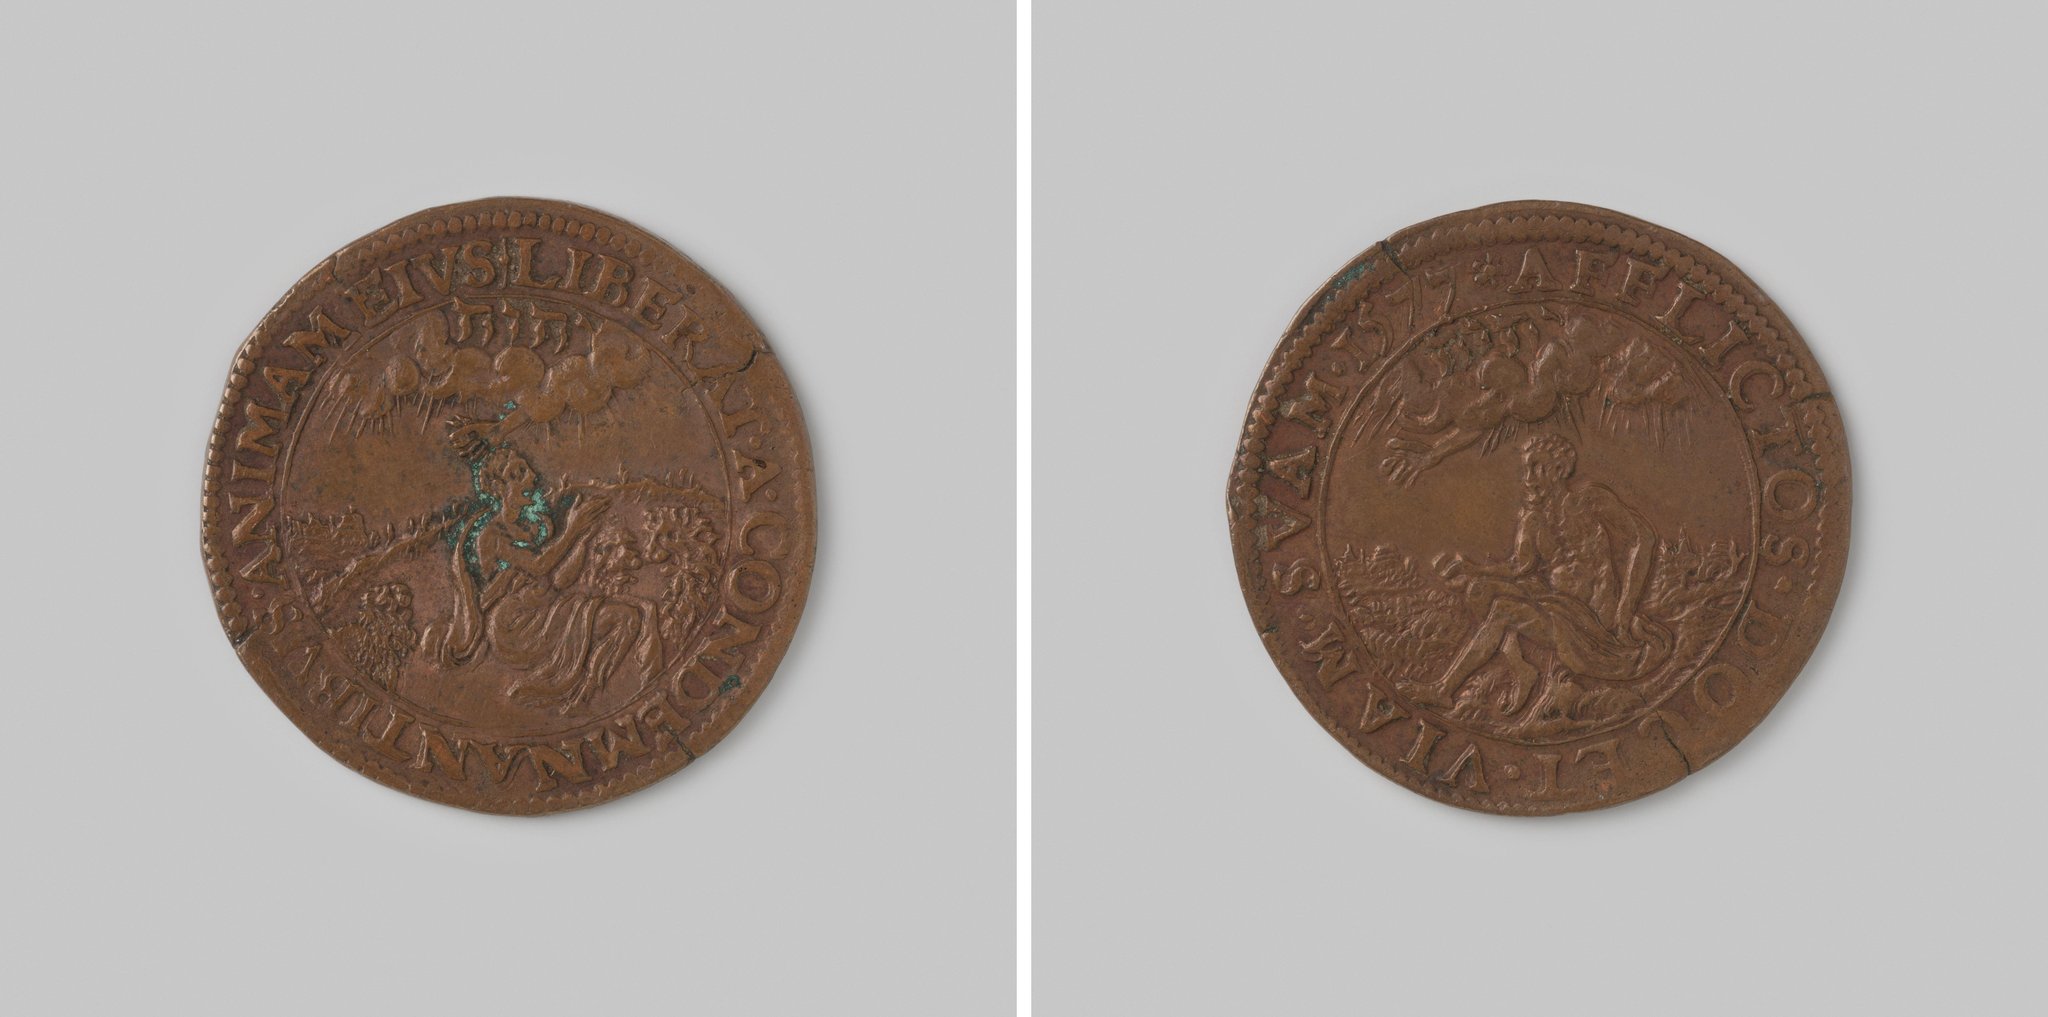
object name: jeton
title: Rekenpenning uit Dordrecht op de moeilijke tijden 1577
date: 1577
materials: copper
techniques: striking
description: Koperen penning,op de voorzijde Elias in de woestijn die brood krijgt van een hand uit de hemel, met omschrift, op de keerzijde Daniël in de leeuwenkuil beschermd door een hand uit de hemel, met omschrift.